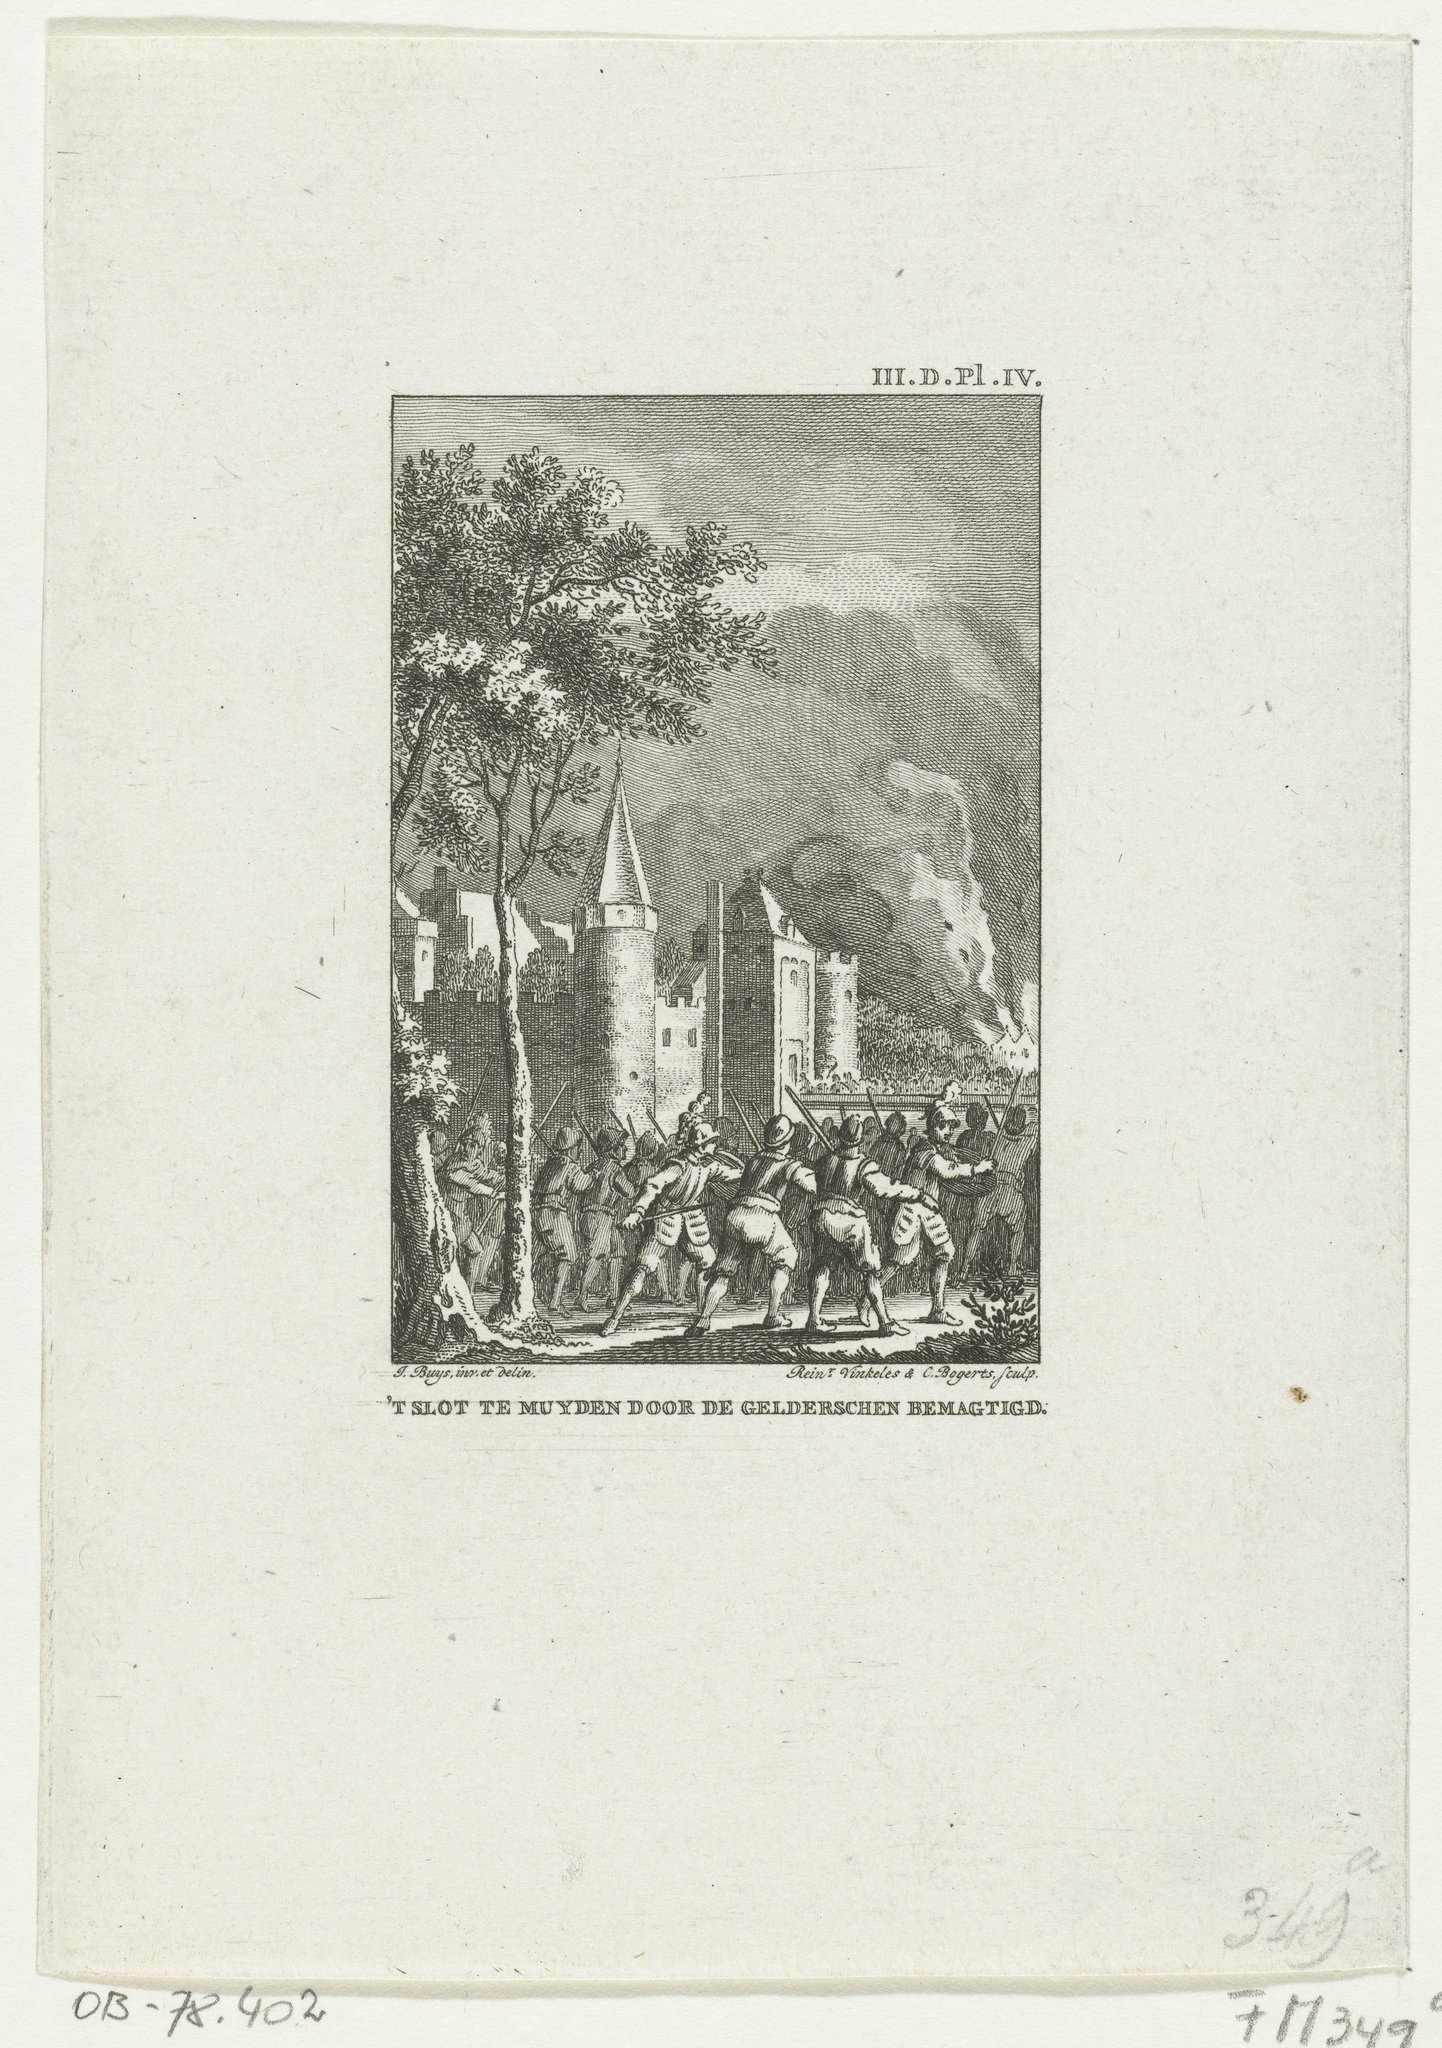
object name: print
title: 't Slot te Muyden door de Gelderschen bematigd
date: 1780-1795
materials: paper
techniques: etching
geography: netherlands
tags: siege, position war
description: Illustratie voor: J. Fokke, Geschiedenissen der Vereenigde Nederlanden voor de vaderlandsche jeugd, Johannes Allart, Amsterdam 1783-1795, 25 delen, dl. III, pl. IV. Staat met de letter.